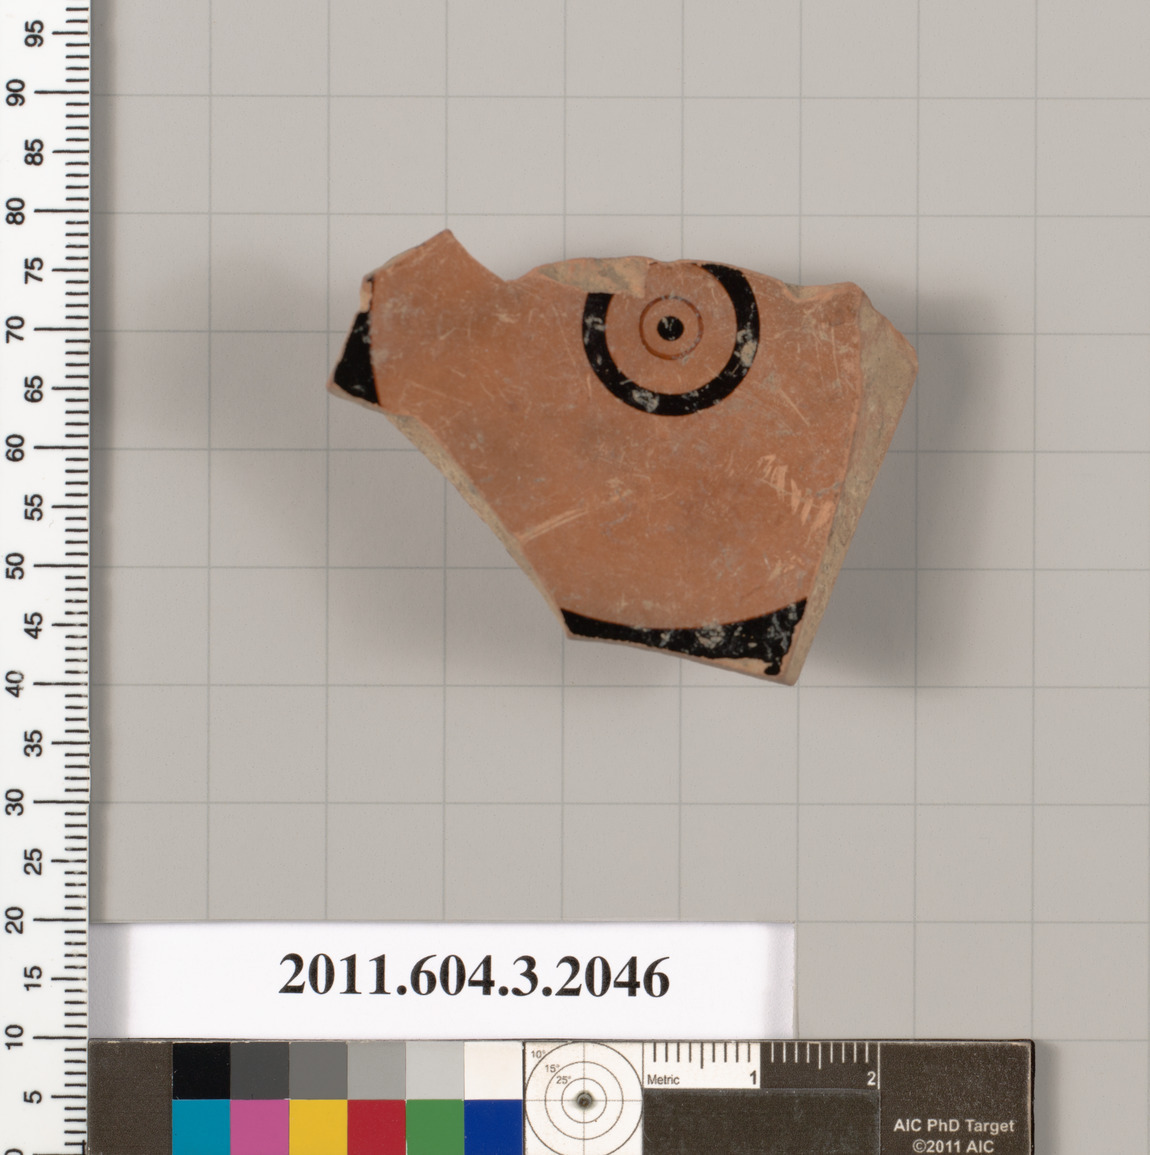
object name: kylix fragment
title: Terracotta fragment of a kylix (drinking cup)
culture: greek, attic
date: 534-468 BCE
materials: terracotta